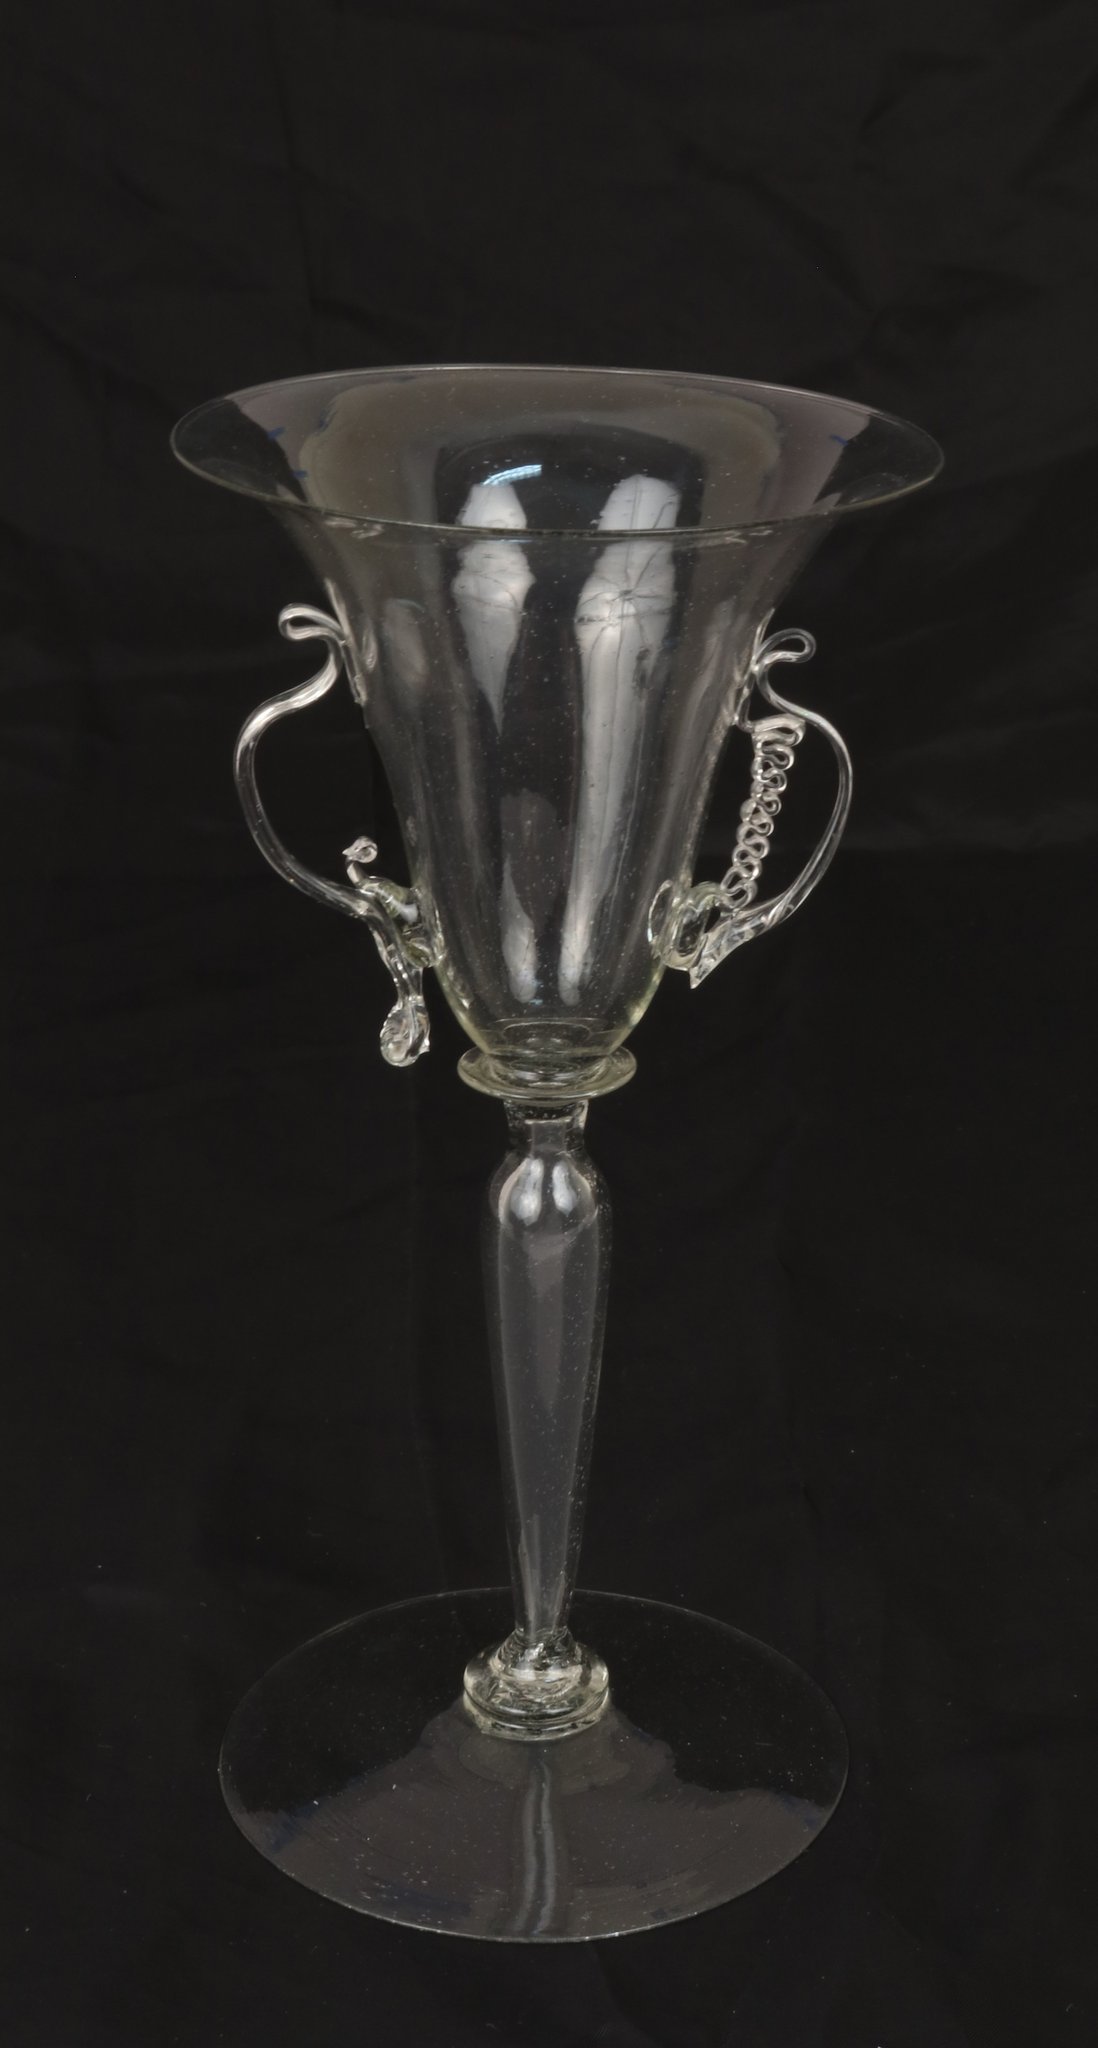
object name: wineglass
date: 1601-1700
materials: glass